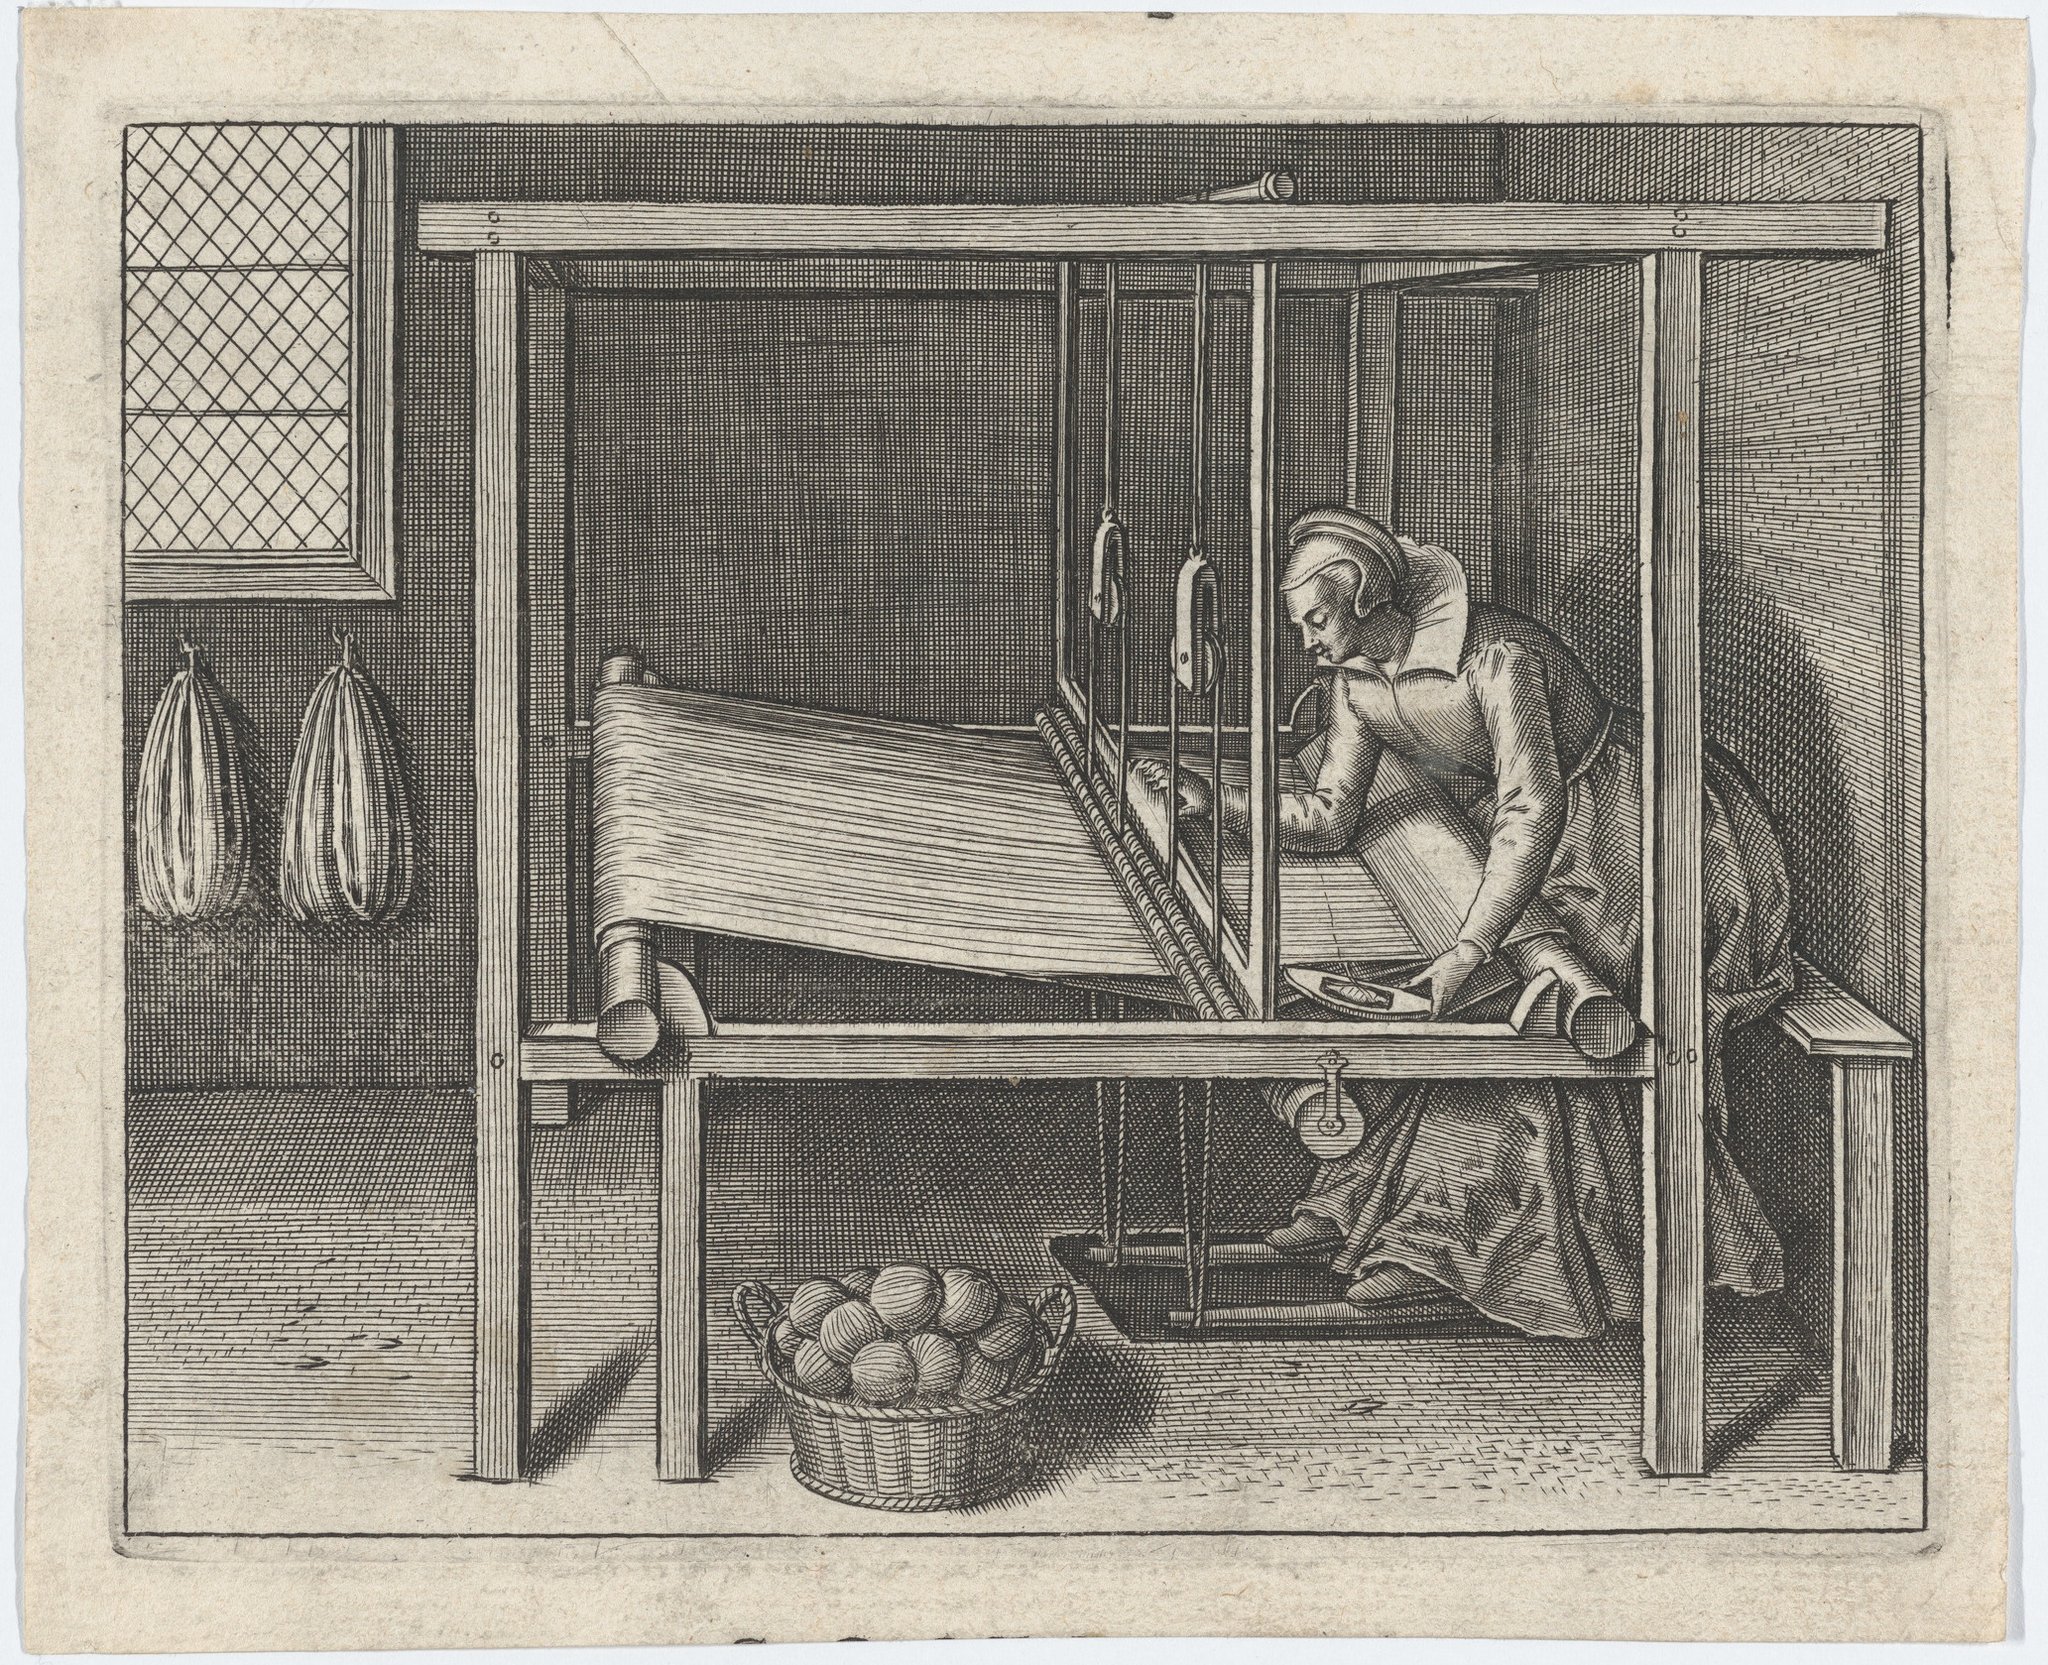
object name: print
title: Enigmes Joyeuses pour les Bons Esprits, Plate 5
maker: jan van haelbeeck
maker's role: artist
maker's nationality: flemish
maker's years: 1595-1635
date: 1615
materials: copper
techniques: engraving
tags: women,working,looms